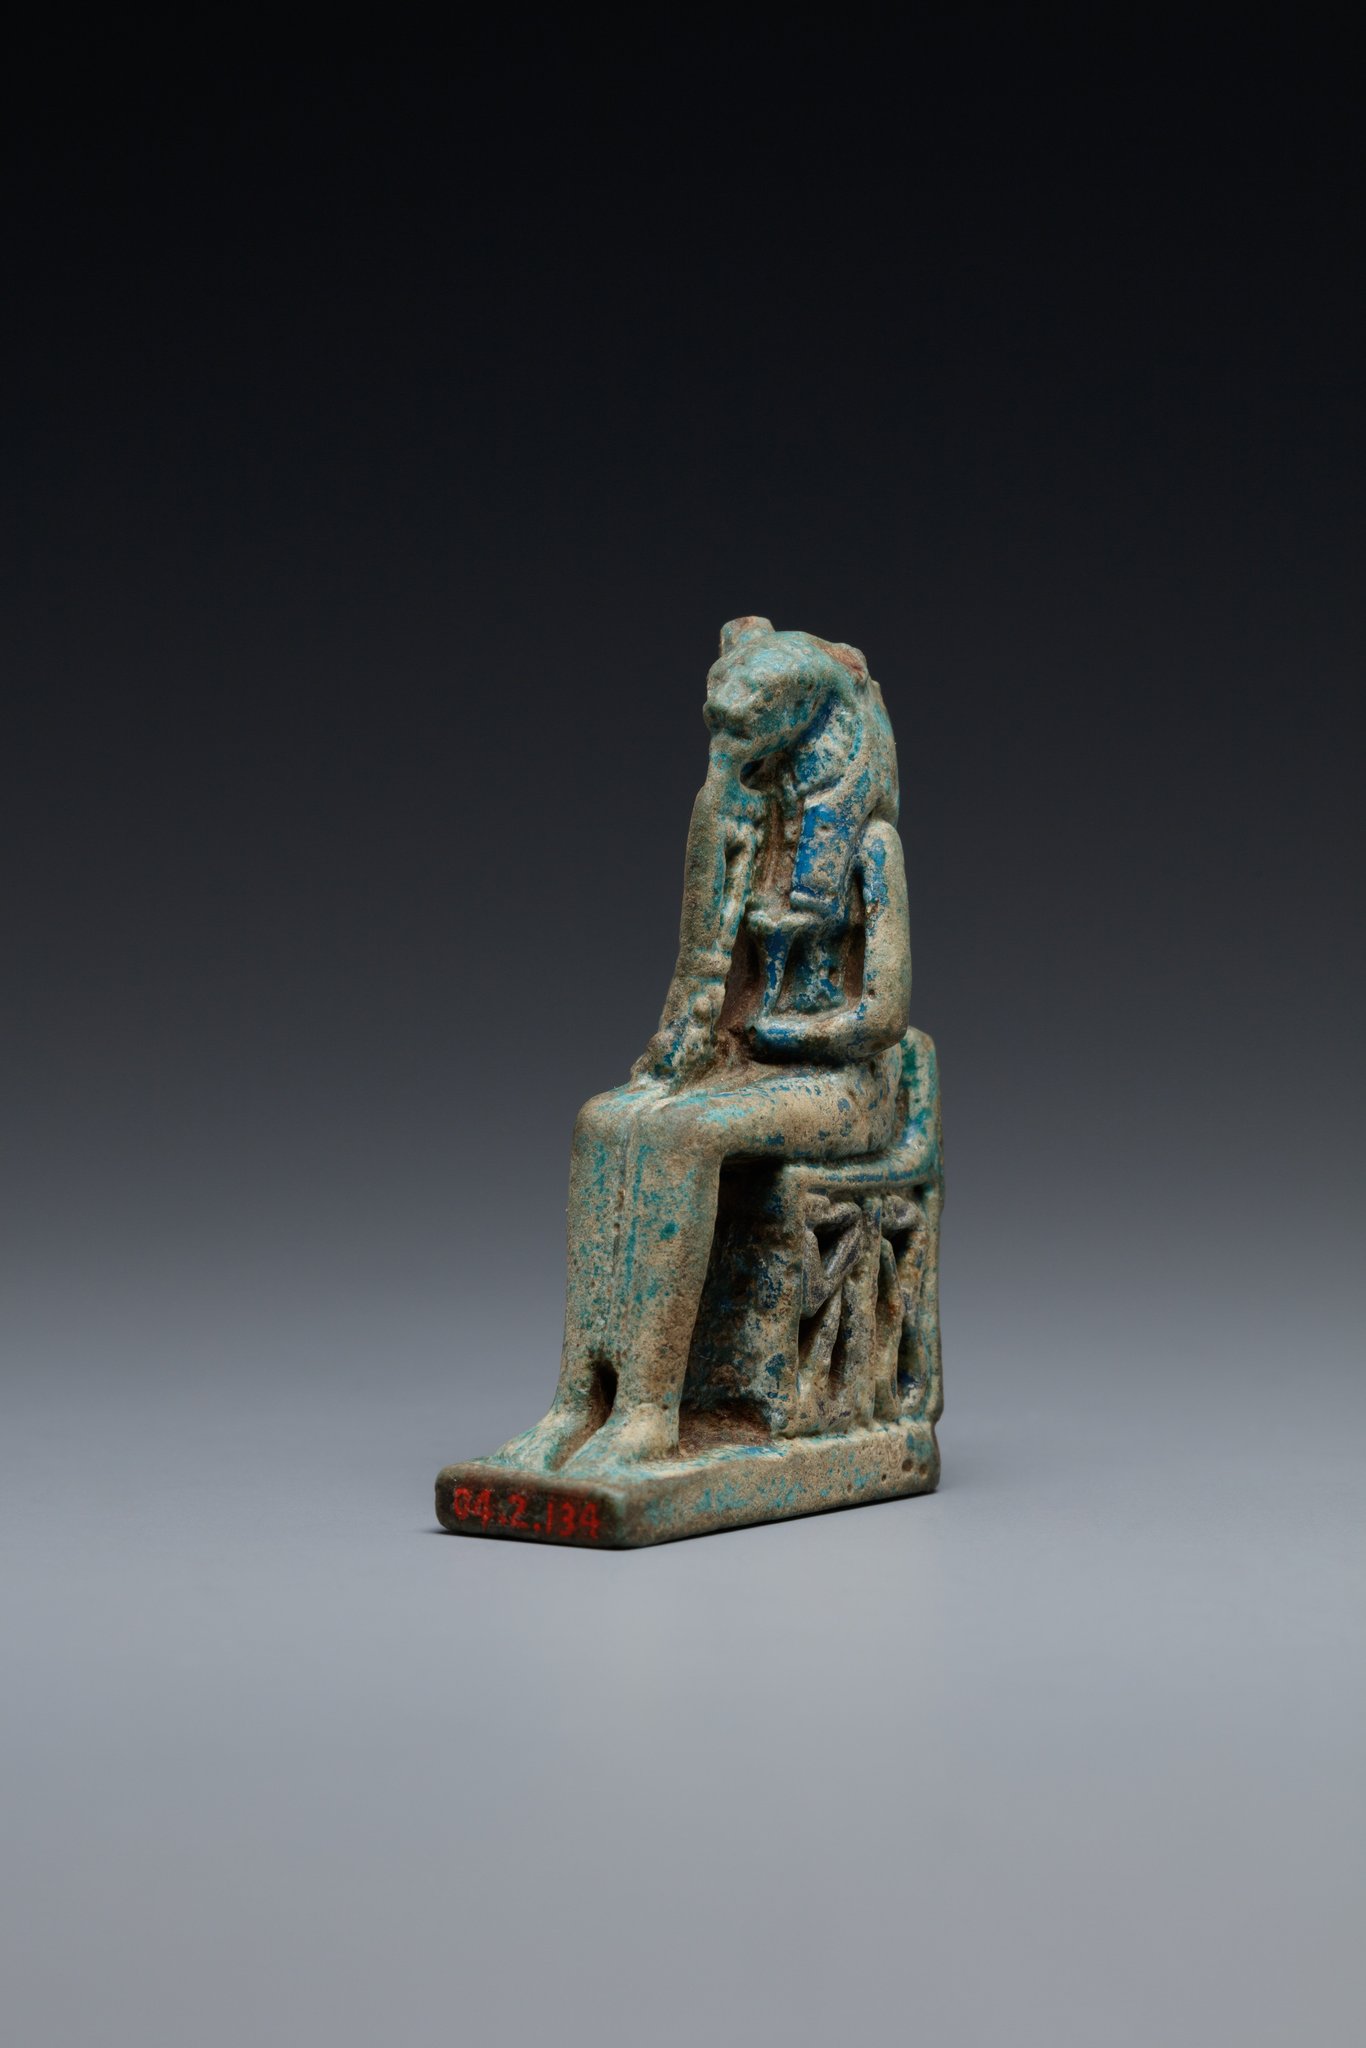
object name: amulet, sakhmet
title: Sakhmet Amulet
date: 664-630 BCE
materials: faience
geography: egypt